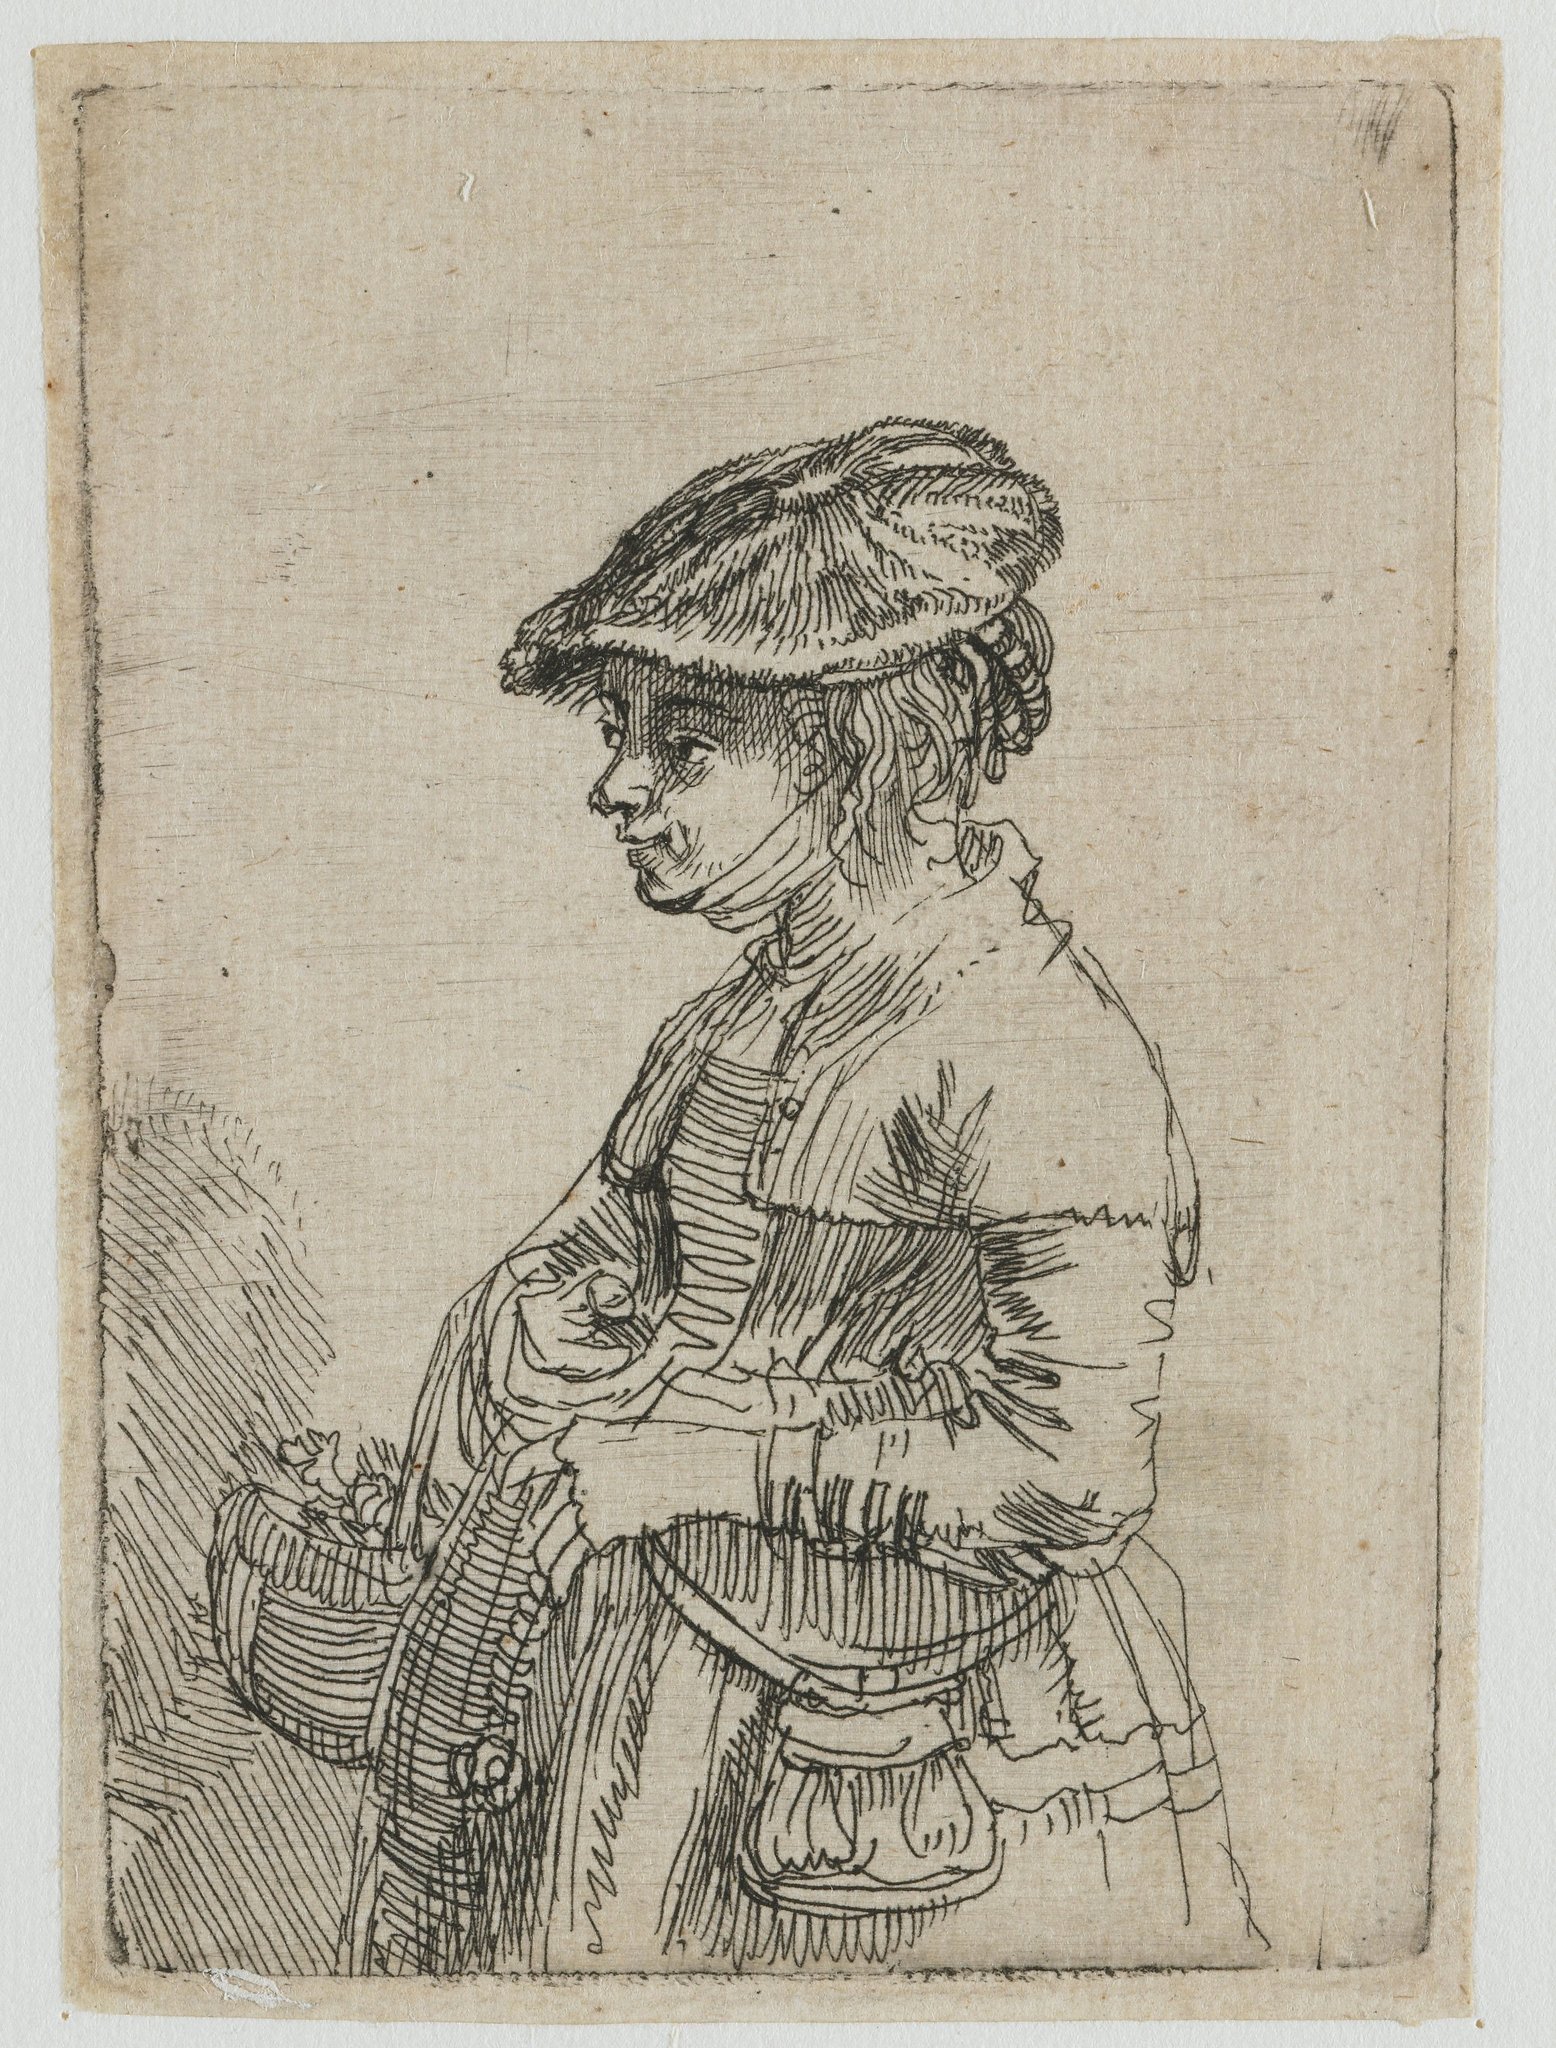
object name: print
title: Girl with a basket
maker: rembrandt van rijn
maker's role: draughtsman, painter, print maker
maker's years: 1606-1669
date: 1642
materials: paper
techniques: etching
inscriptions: mark: Lugt 2228, mark: Lugt 3020-3023, mark: Lugt 1375, mark: Lugt 654, mark: Lugt 402, mark: Lugt 533 b